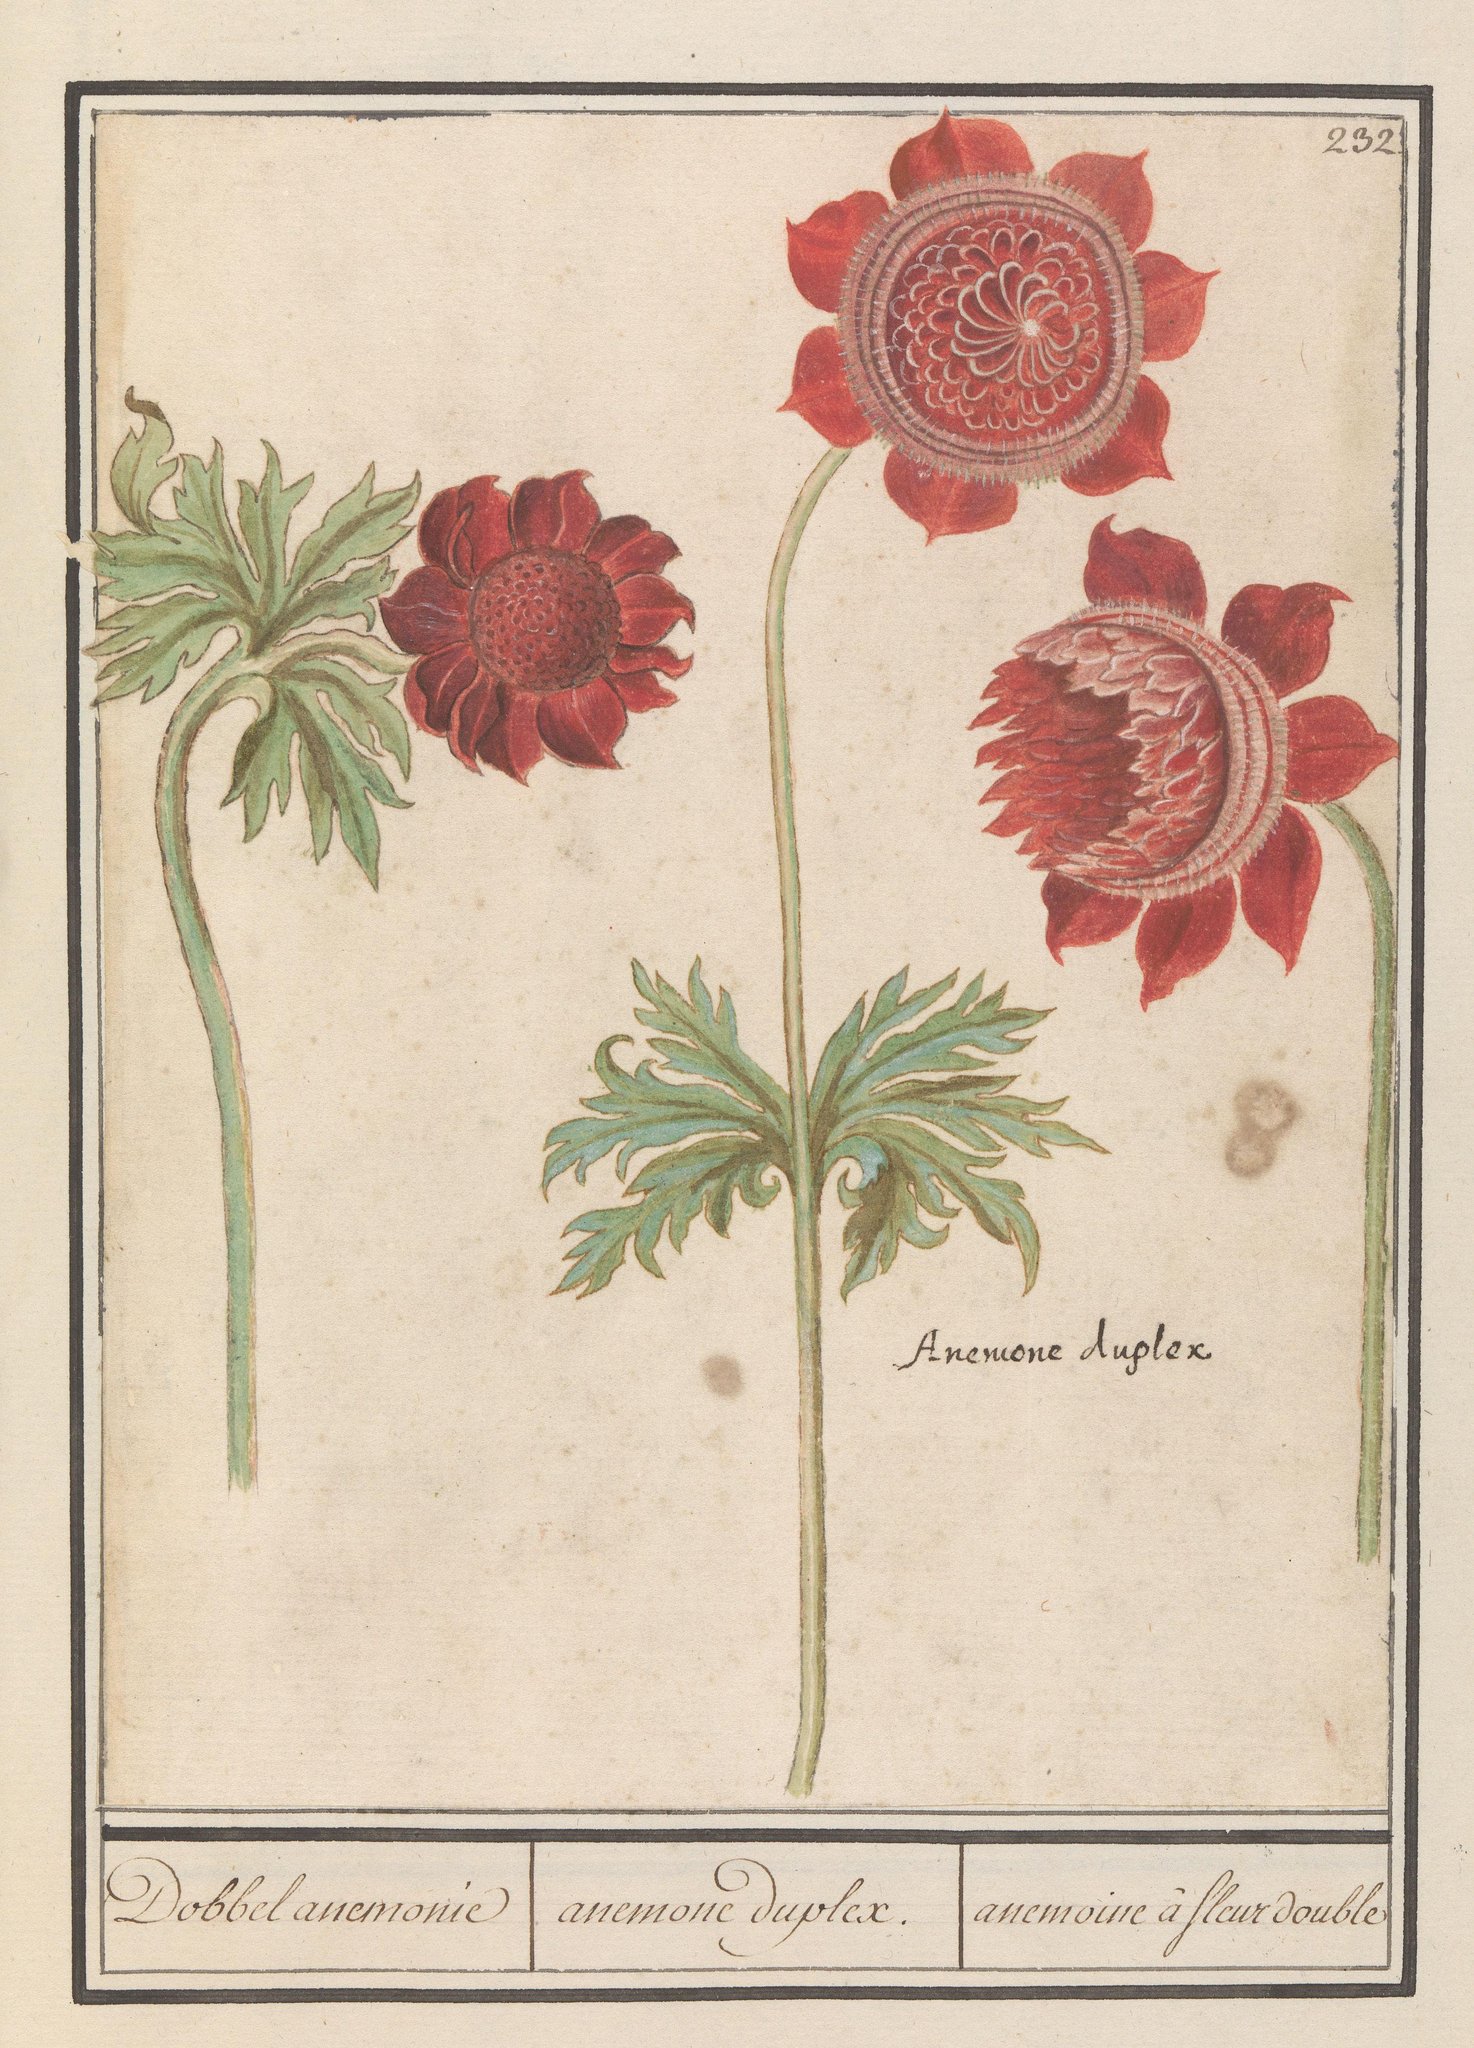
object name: drawing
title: Pioenroos (Paeonia) en Anemoon (Anemone)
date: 1596-1610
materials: chalk, paint, ink, paper, watercolor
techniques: brush, pen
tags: flowers: anemone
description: Rode anemonen. Genummerd rechtsboven: 232. Rechts de Latijnse naam. Onderdeel van het derde album met tekeningen van bloemen en planten. Tiende van twaalf albums met tekeningen van dieren, vogels en planten bekend rond 1600, gemaakt in opdracht van keizer Rudolf II. Met toelichting in Nederlands, Latijn en Frans.